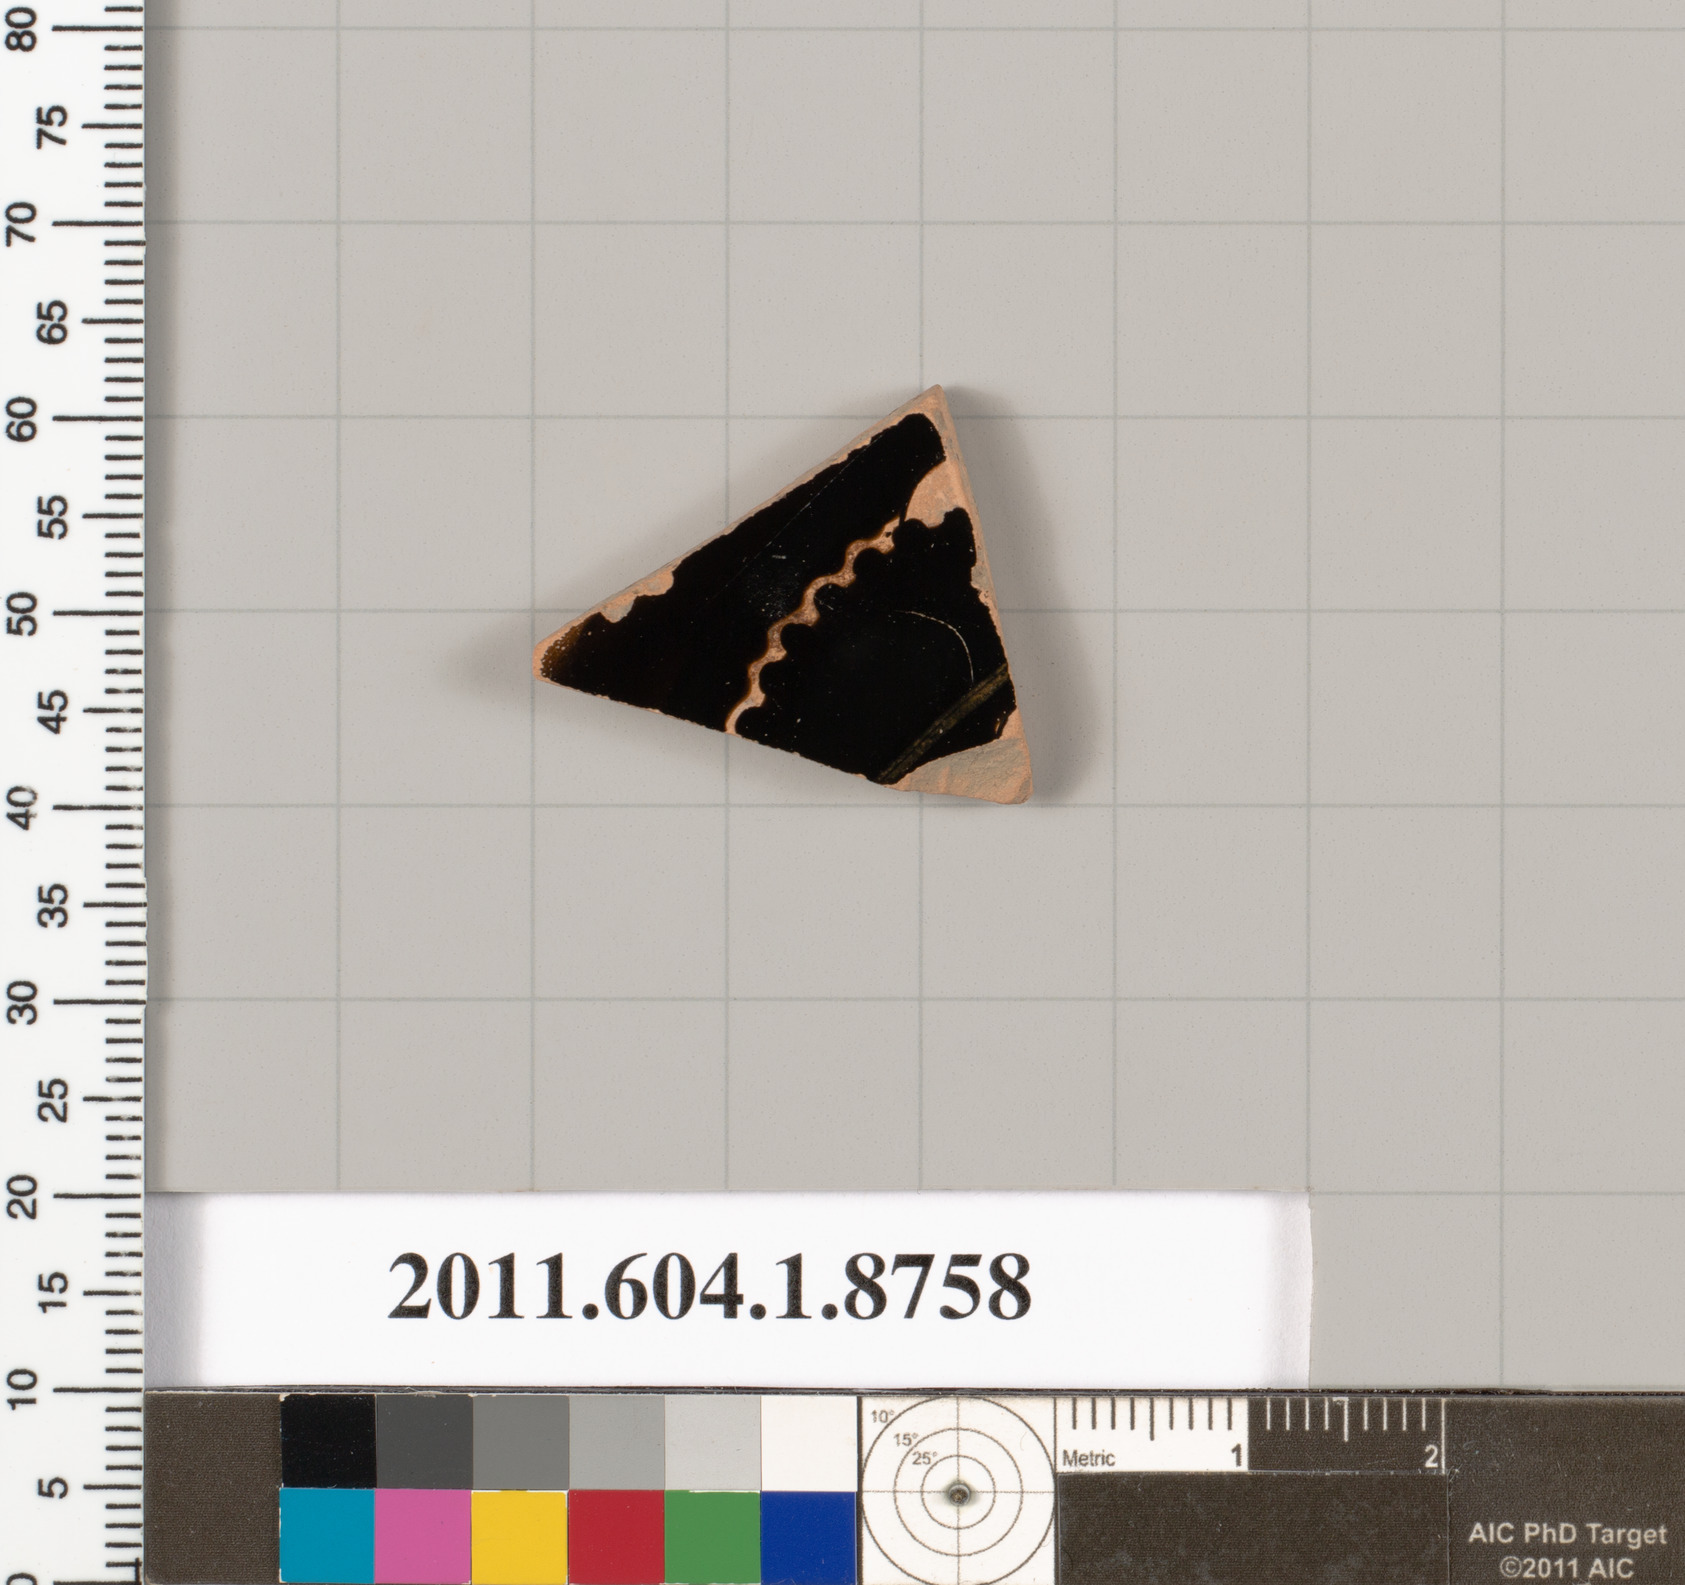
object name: kylix fragment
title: Terracotta fragment of a kylix (drinking cup)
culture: greek, attic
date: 500-480 BCE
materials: terracotta